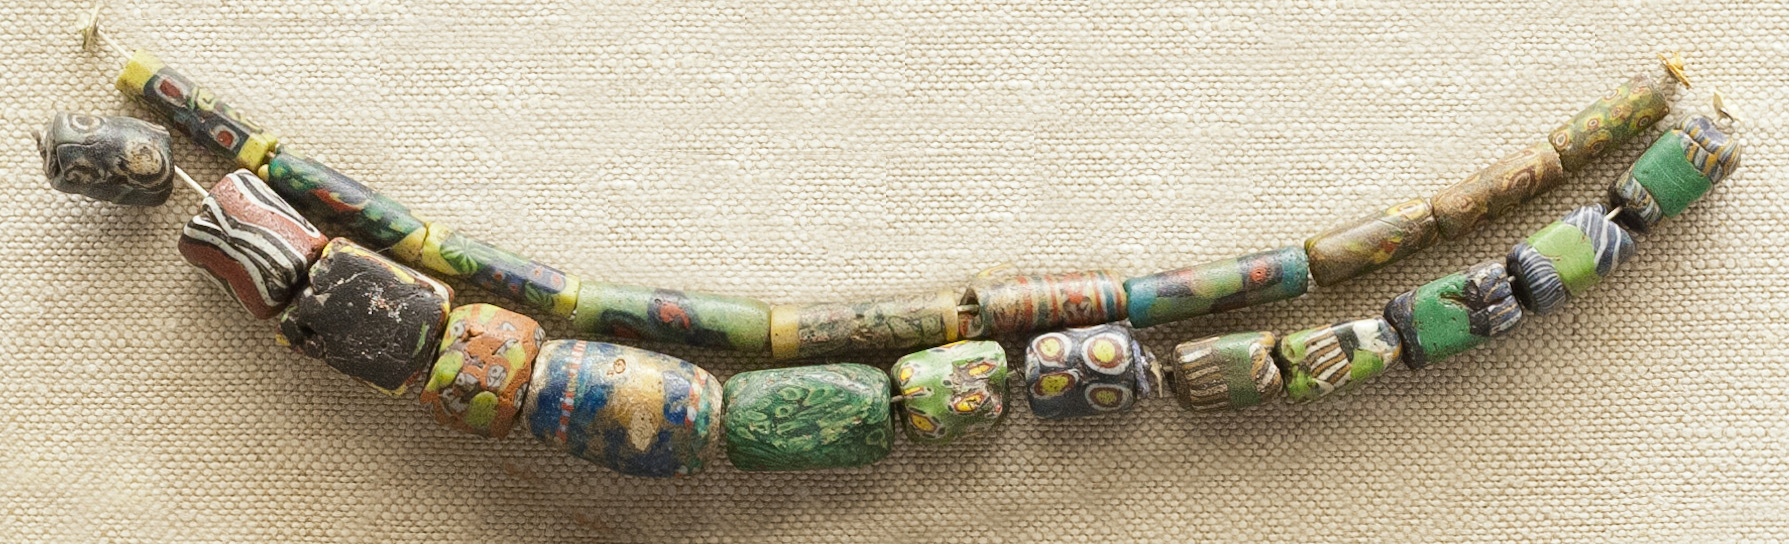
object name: bead, string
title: String of 8 Beads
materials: glass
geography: egypt